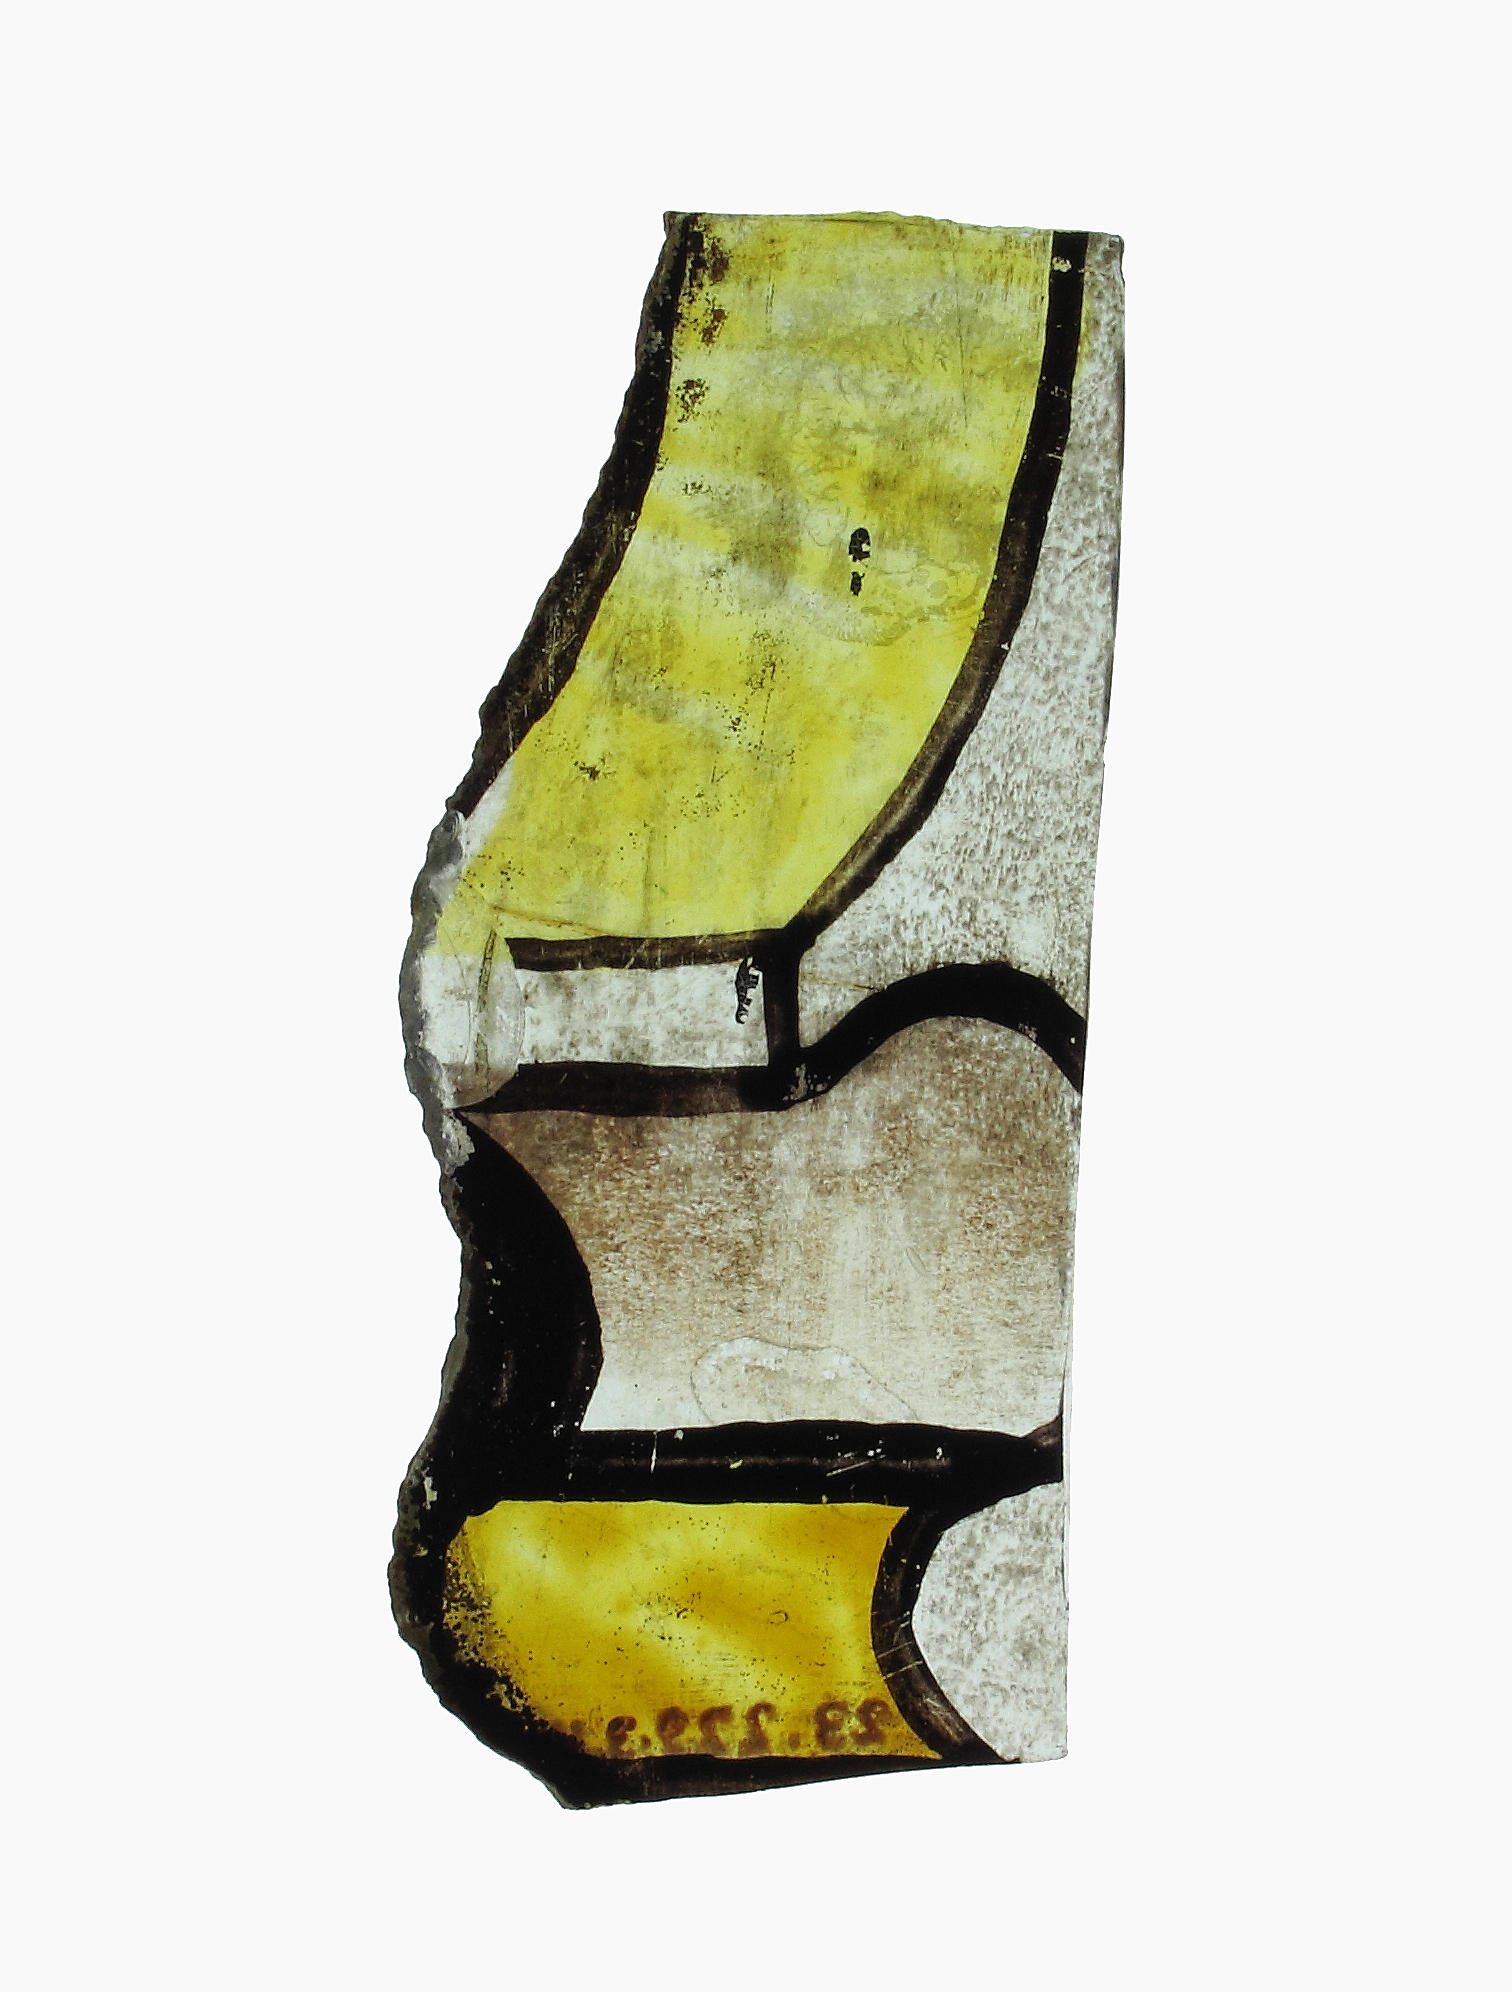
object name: fragment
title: Glass Fragment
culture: french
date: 1501-1600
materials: glass